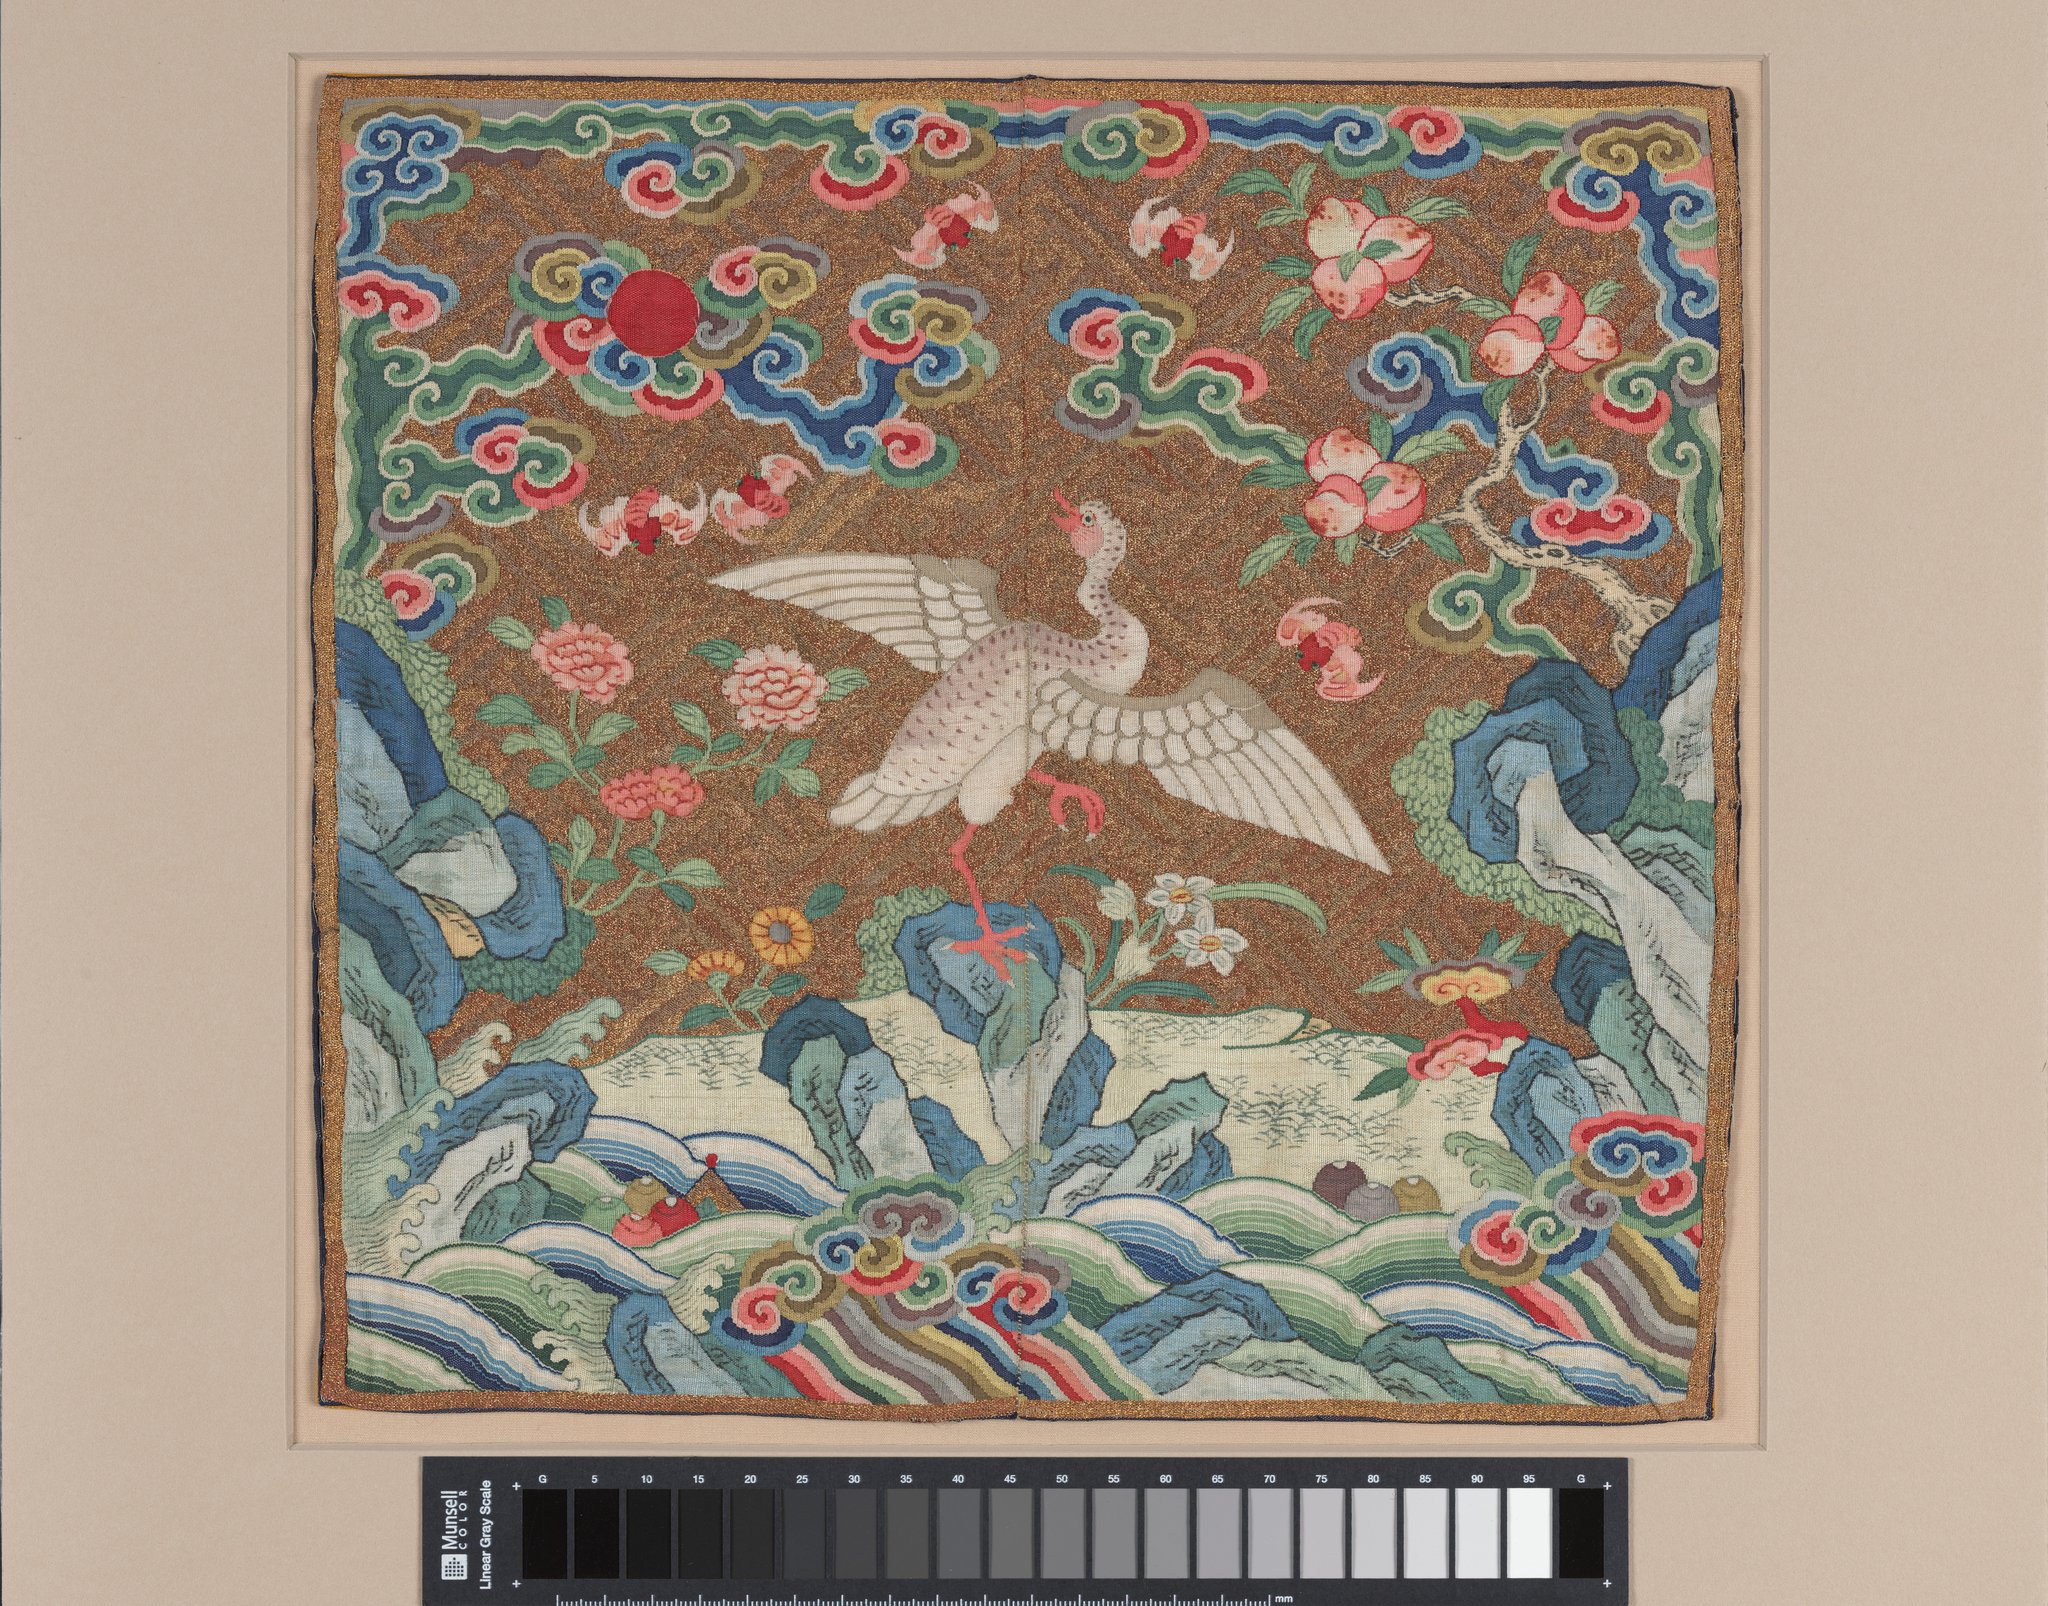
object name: rank badge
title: Rank Badge with Bird and Flower Motifs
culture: chinese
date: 1701-1800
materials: metal thread, silk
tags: bats,birds,badges